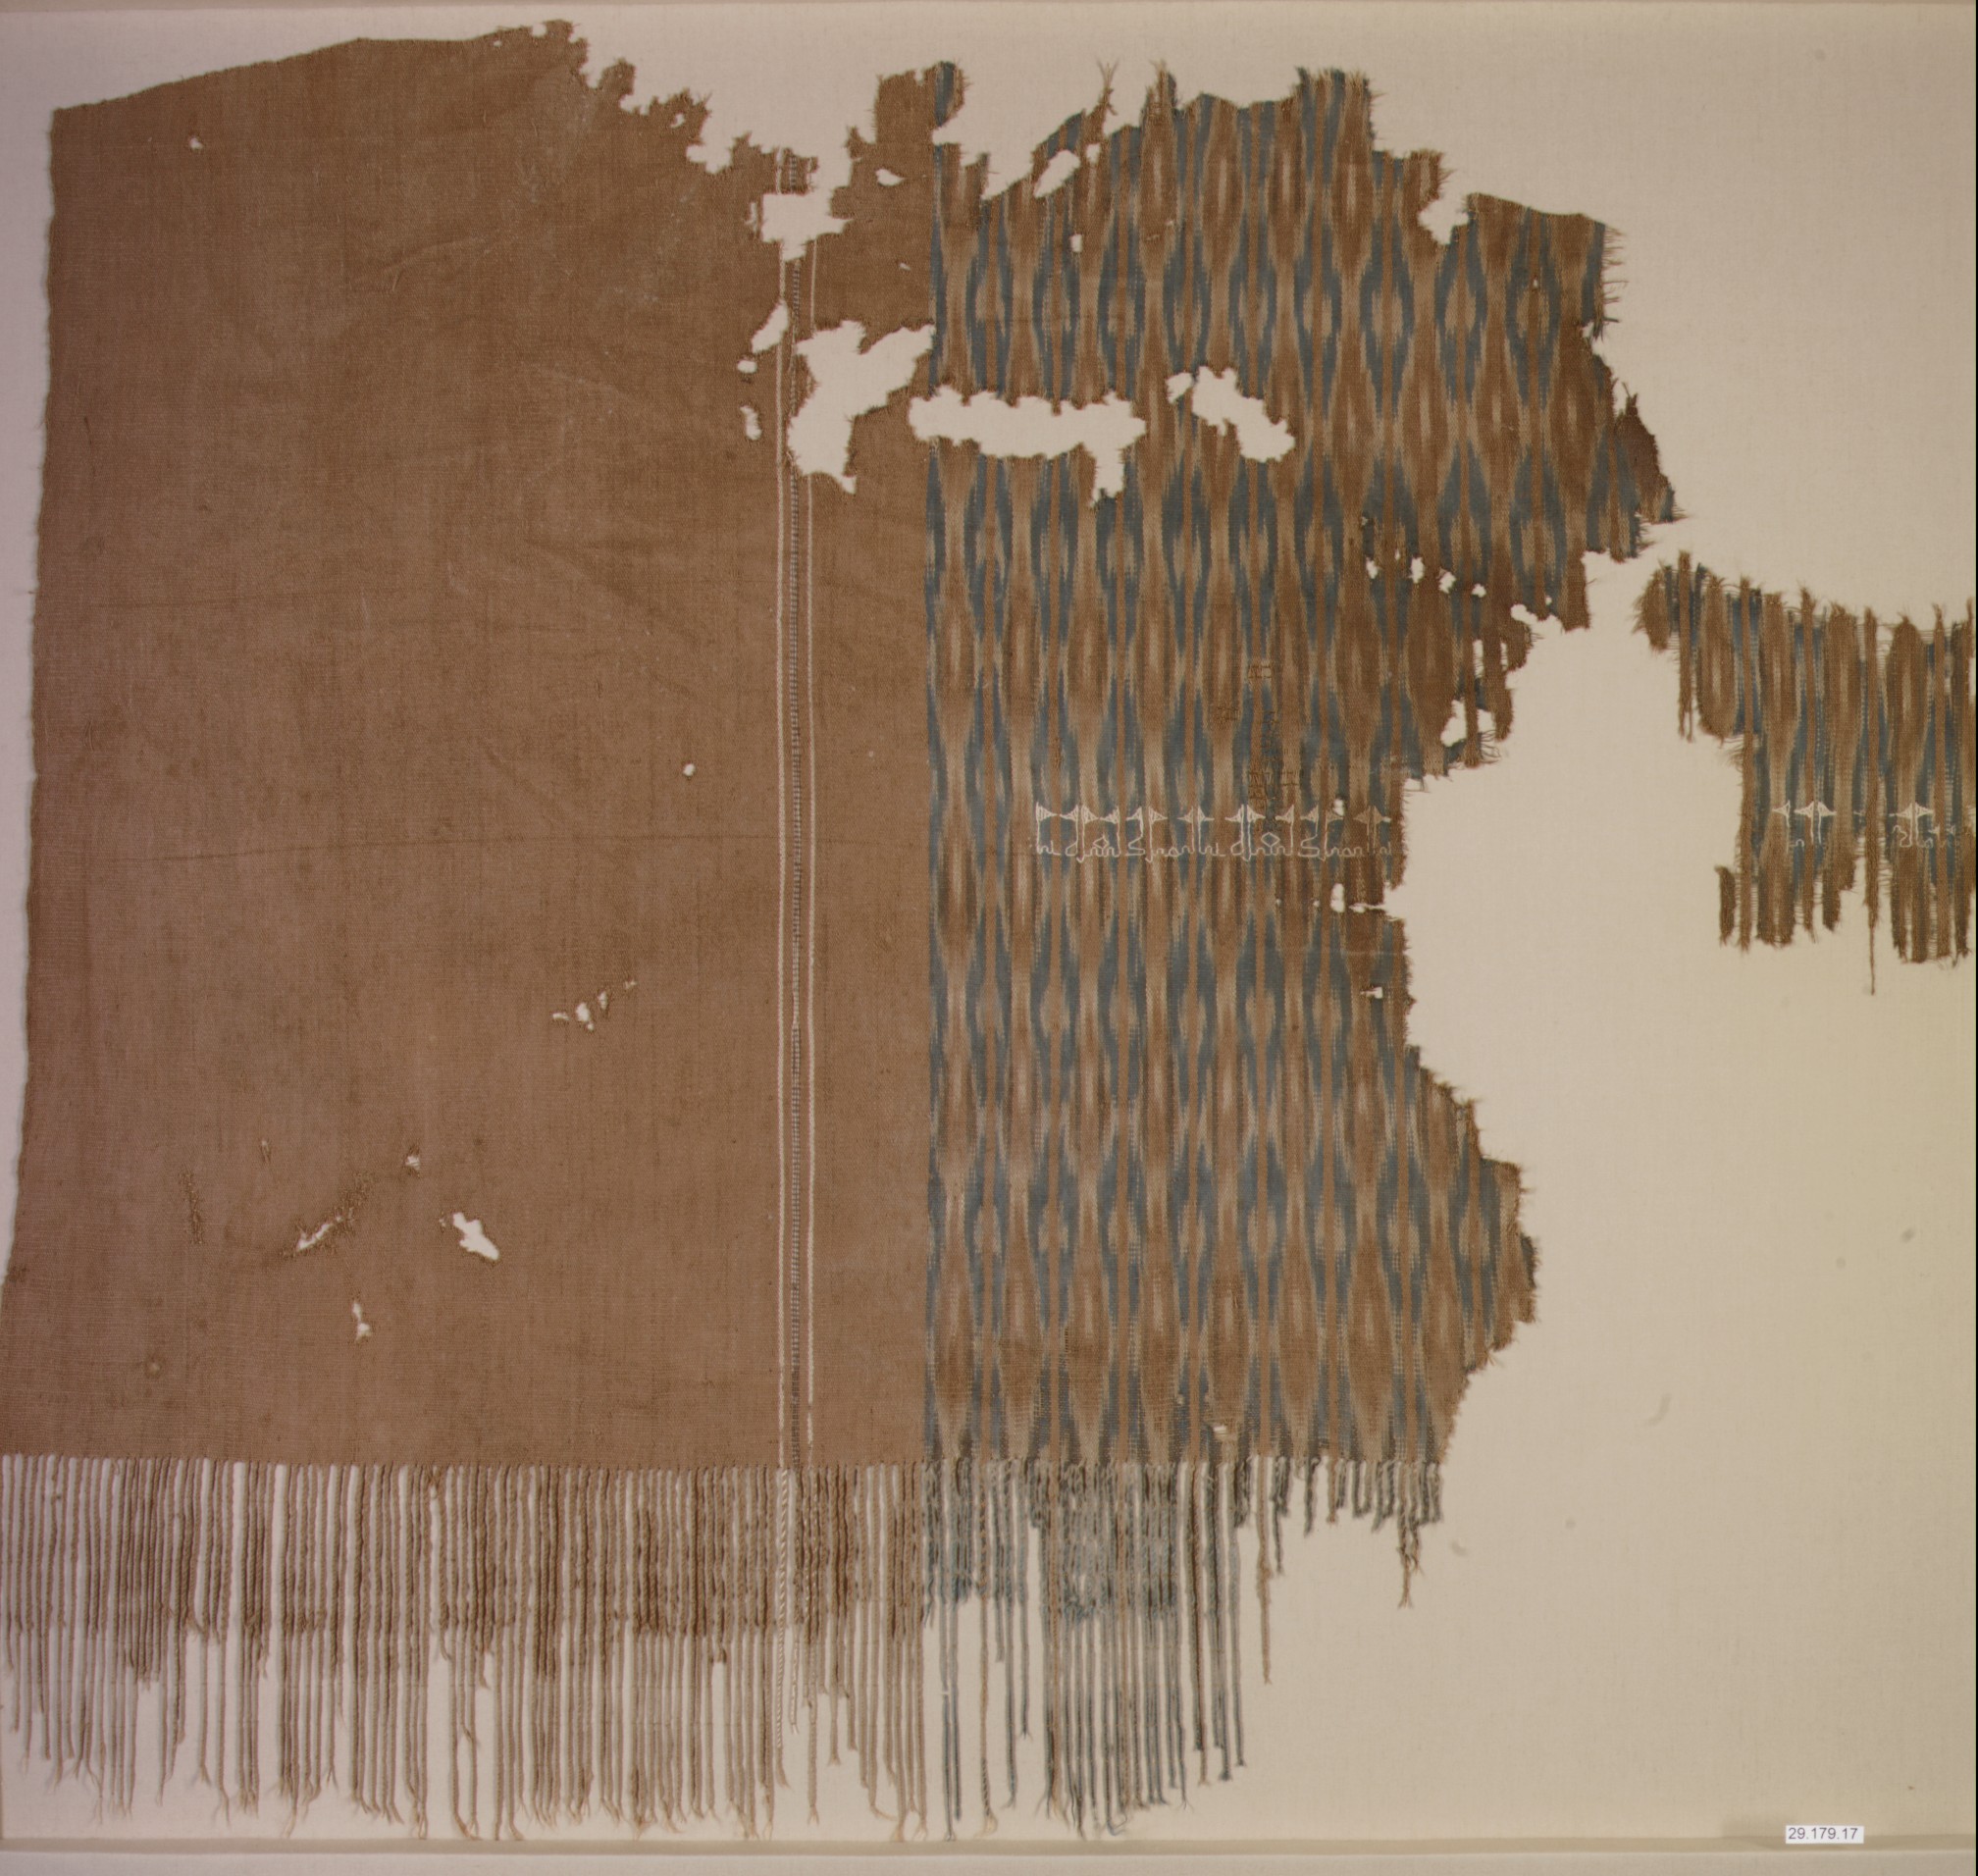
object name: textile fragment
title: Fragment of an Embroidered Textile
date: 901-1000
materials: cotton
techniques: dyeing, embroidery, weave, resist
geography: yemen